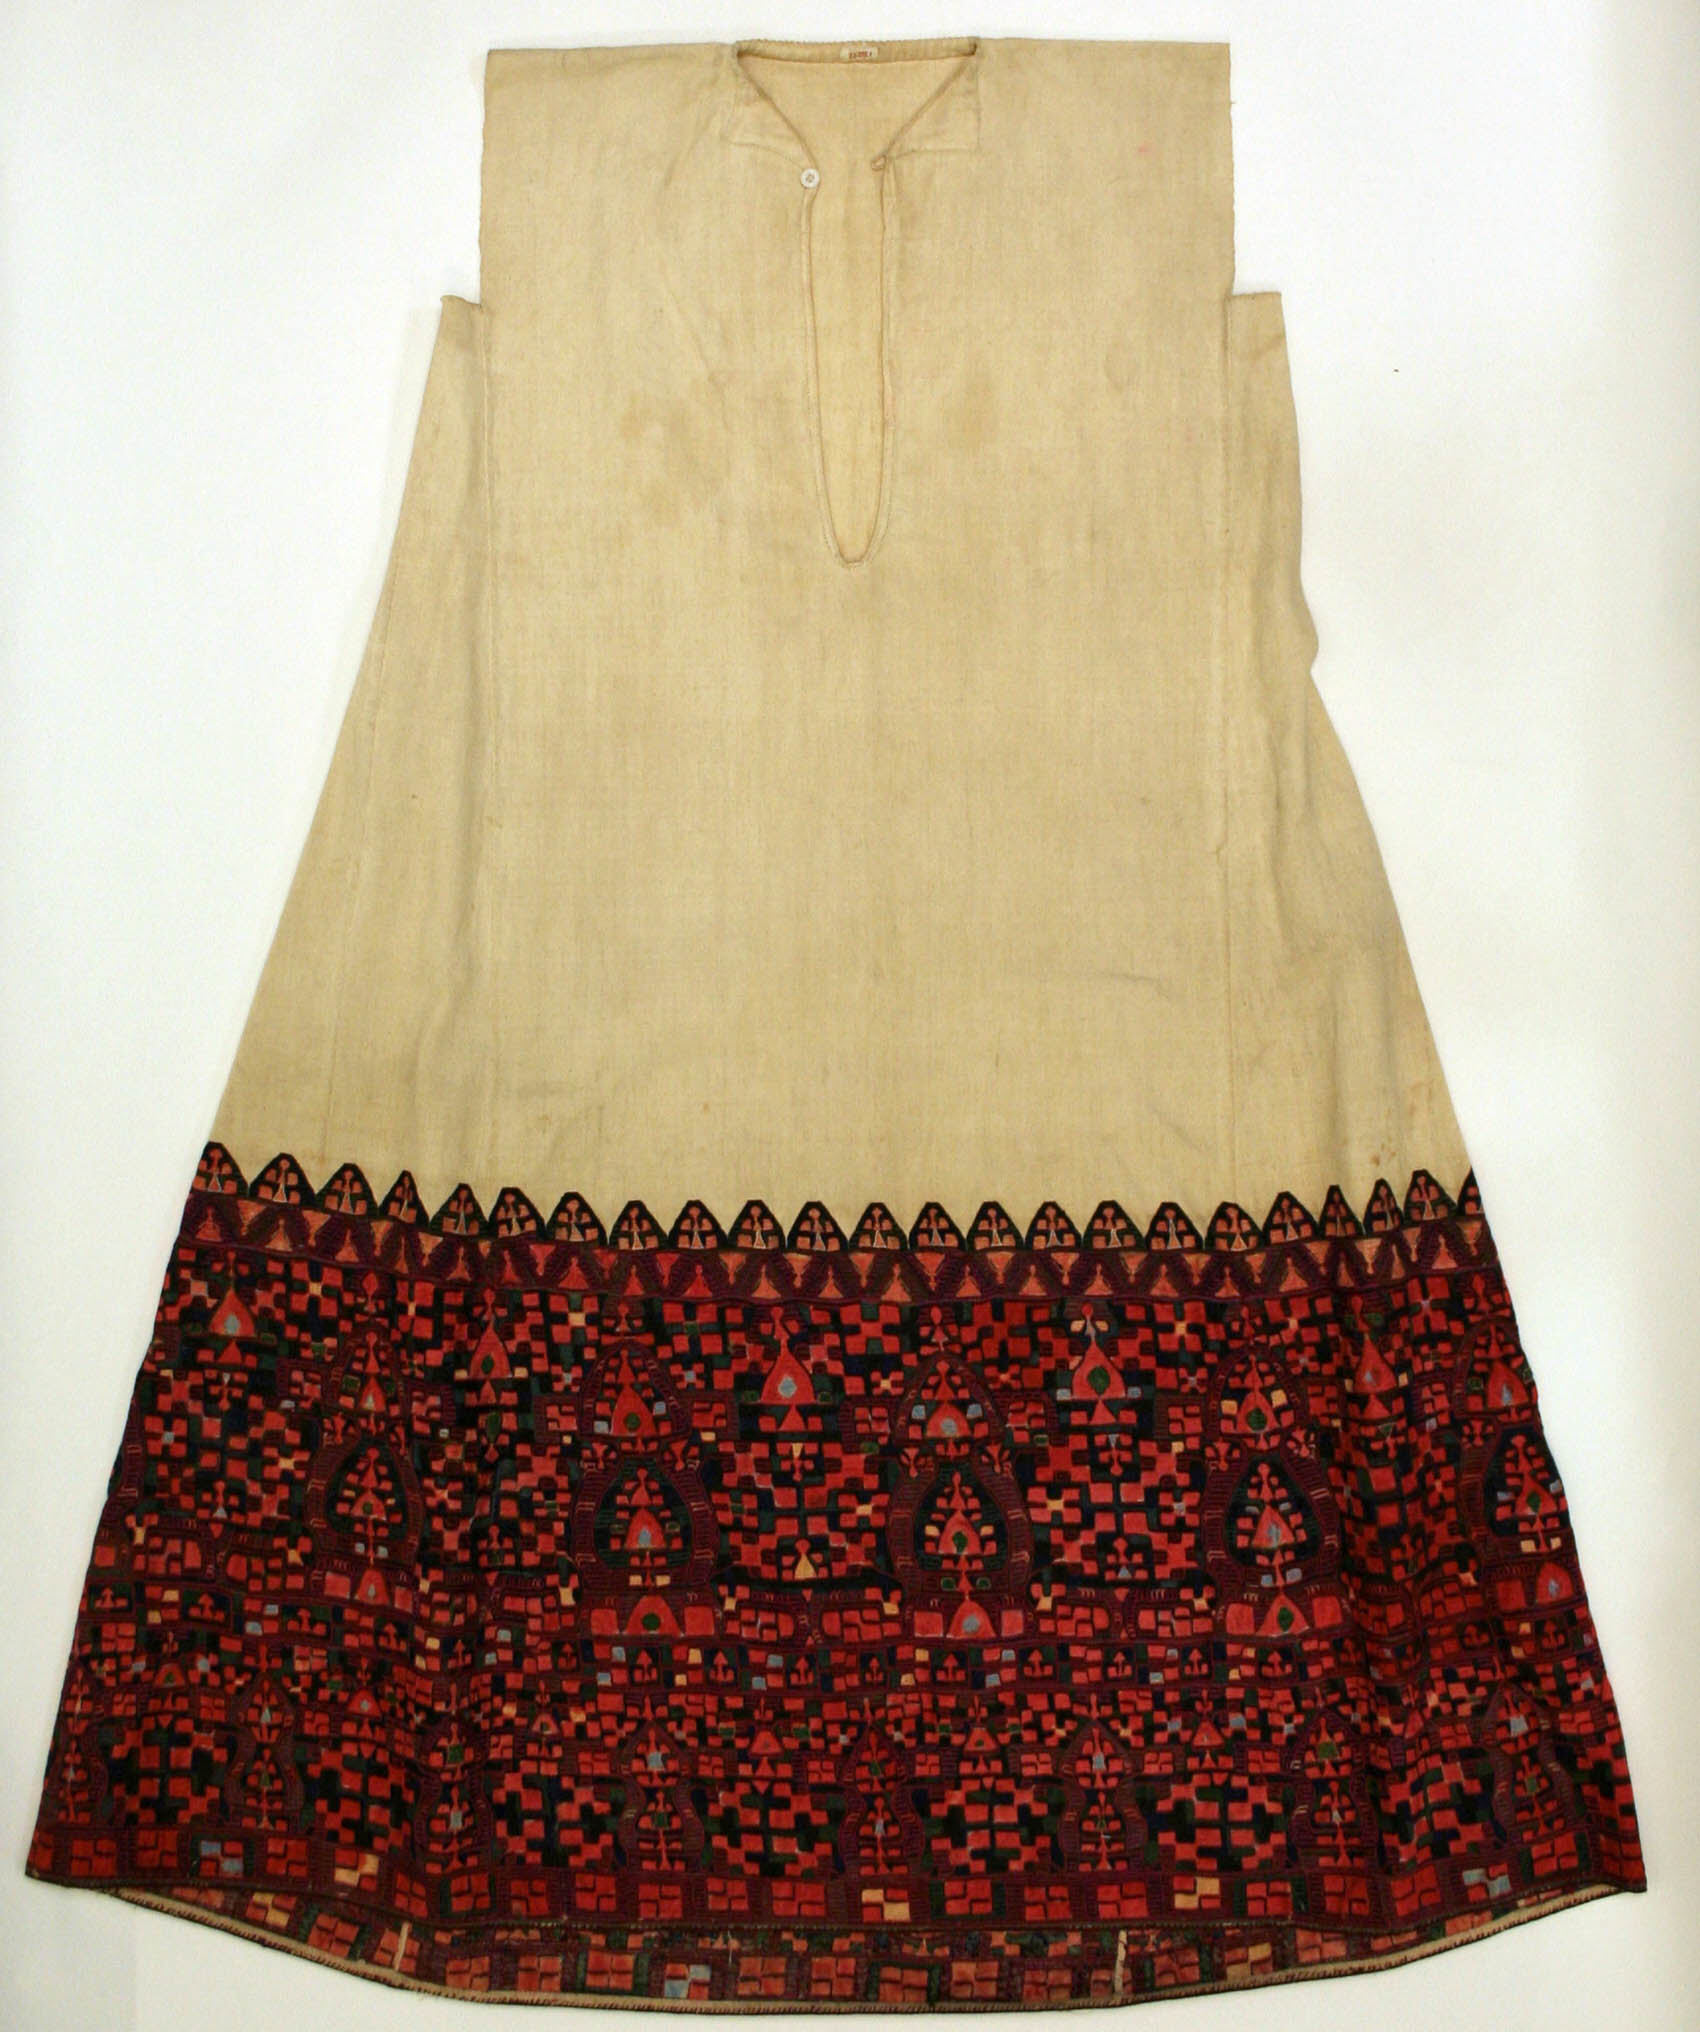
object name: dress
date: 1801-1900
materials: cotton, silk